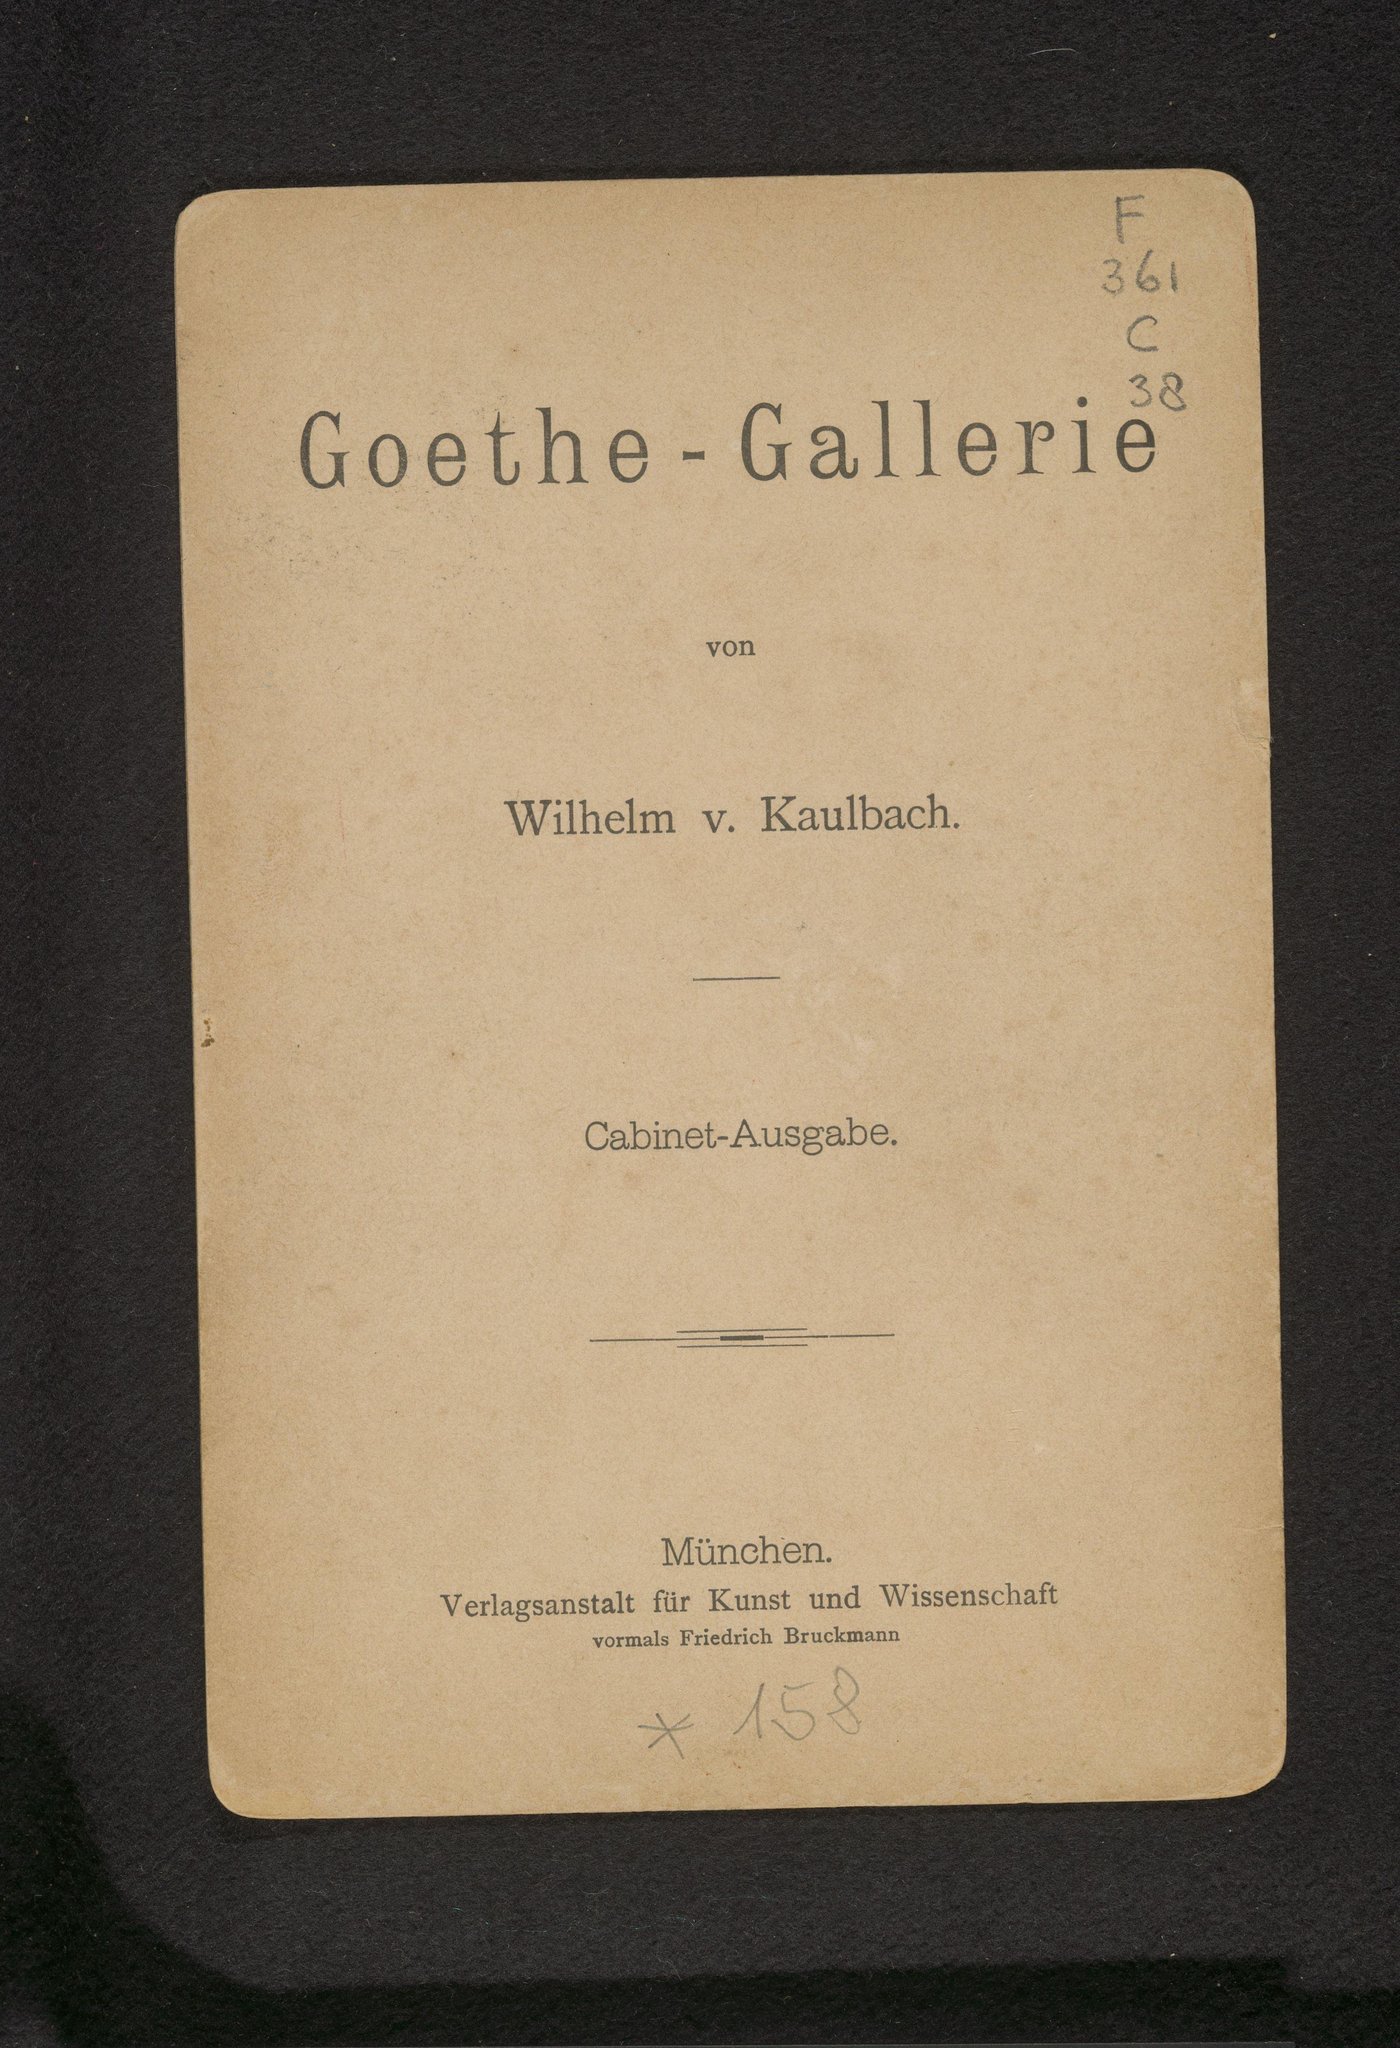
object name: book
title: Goethe-Gallerie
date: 1885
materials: cardboard, paper, textile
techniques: albumen print, printing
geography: munich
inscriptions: annotation: ‘ex-N/ 1993’